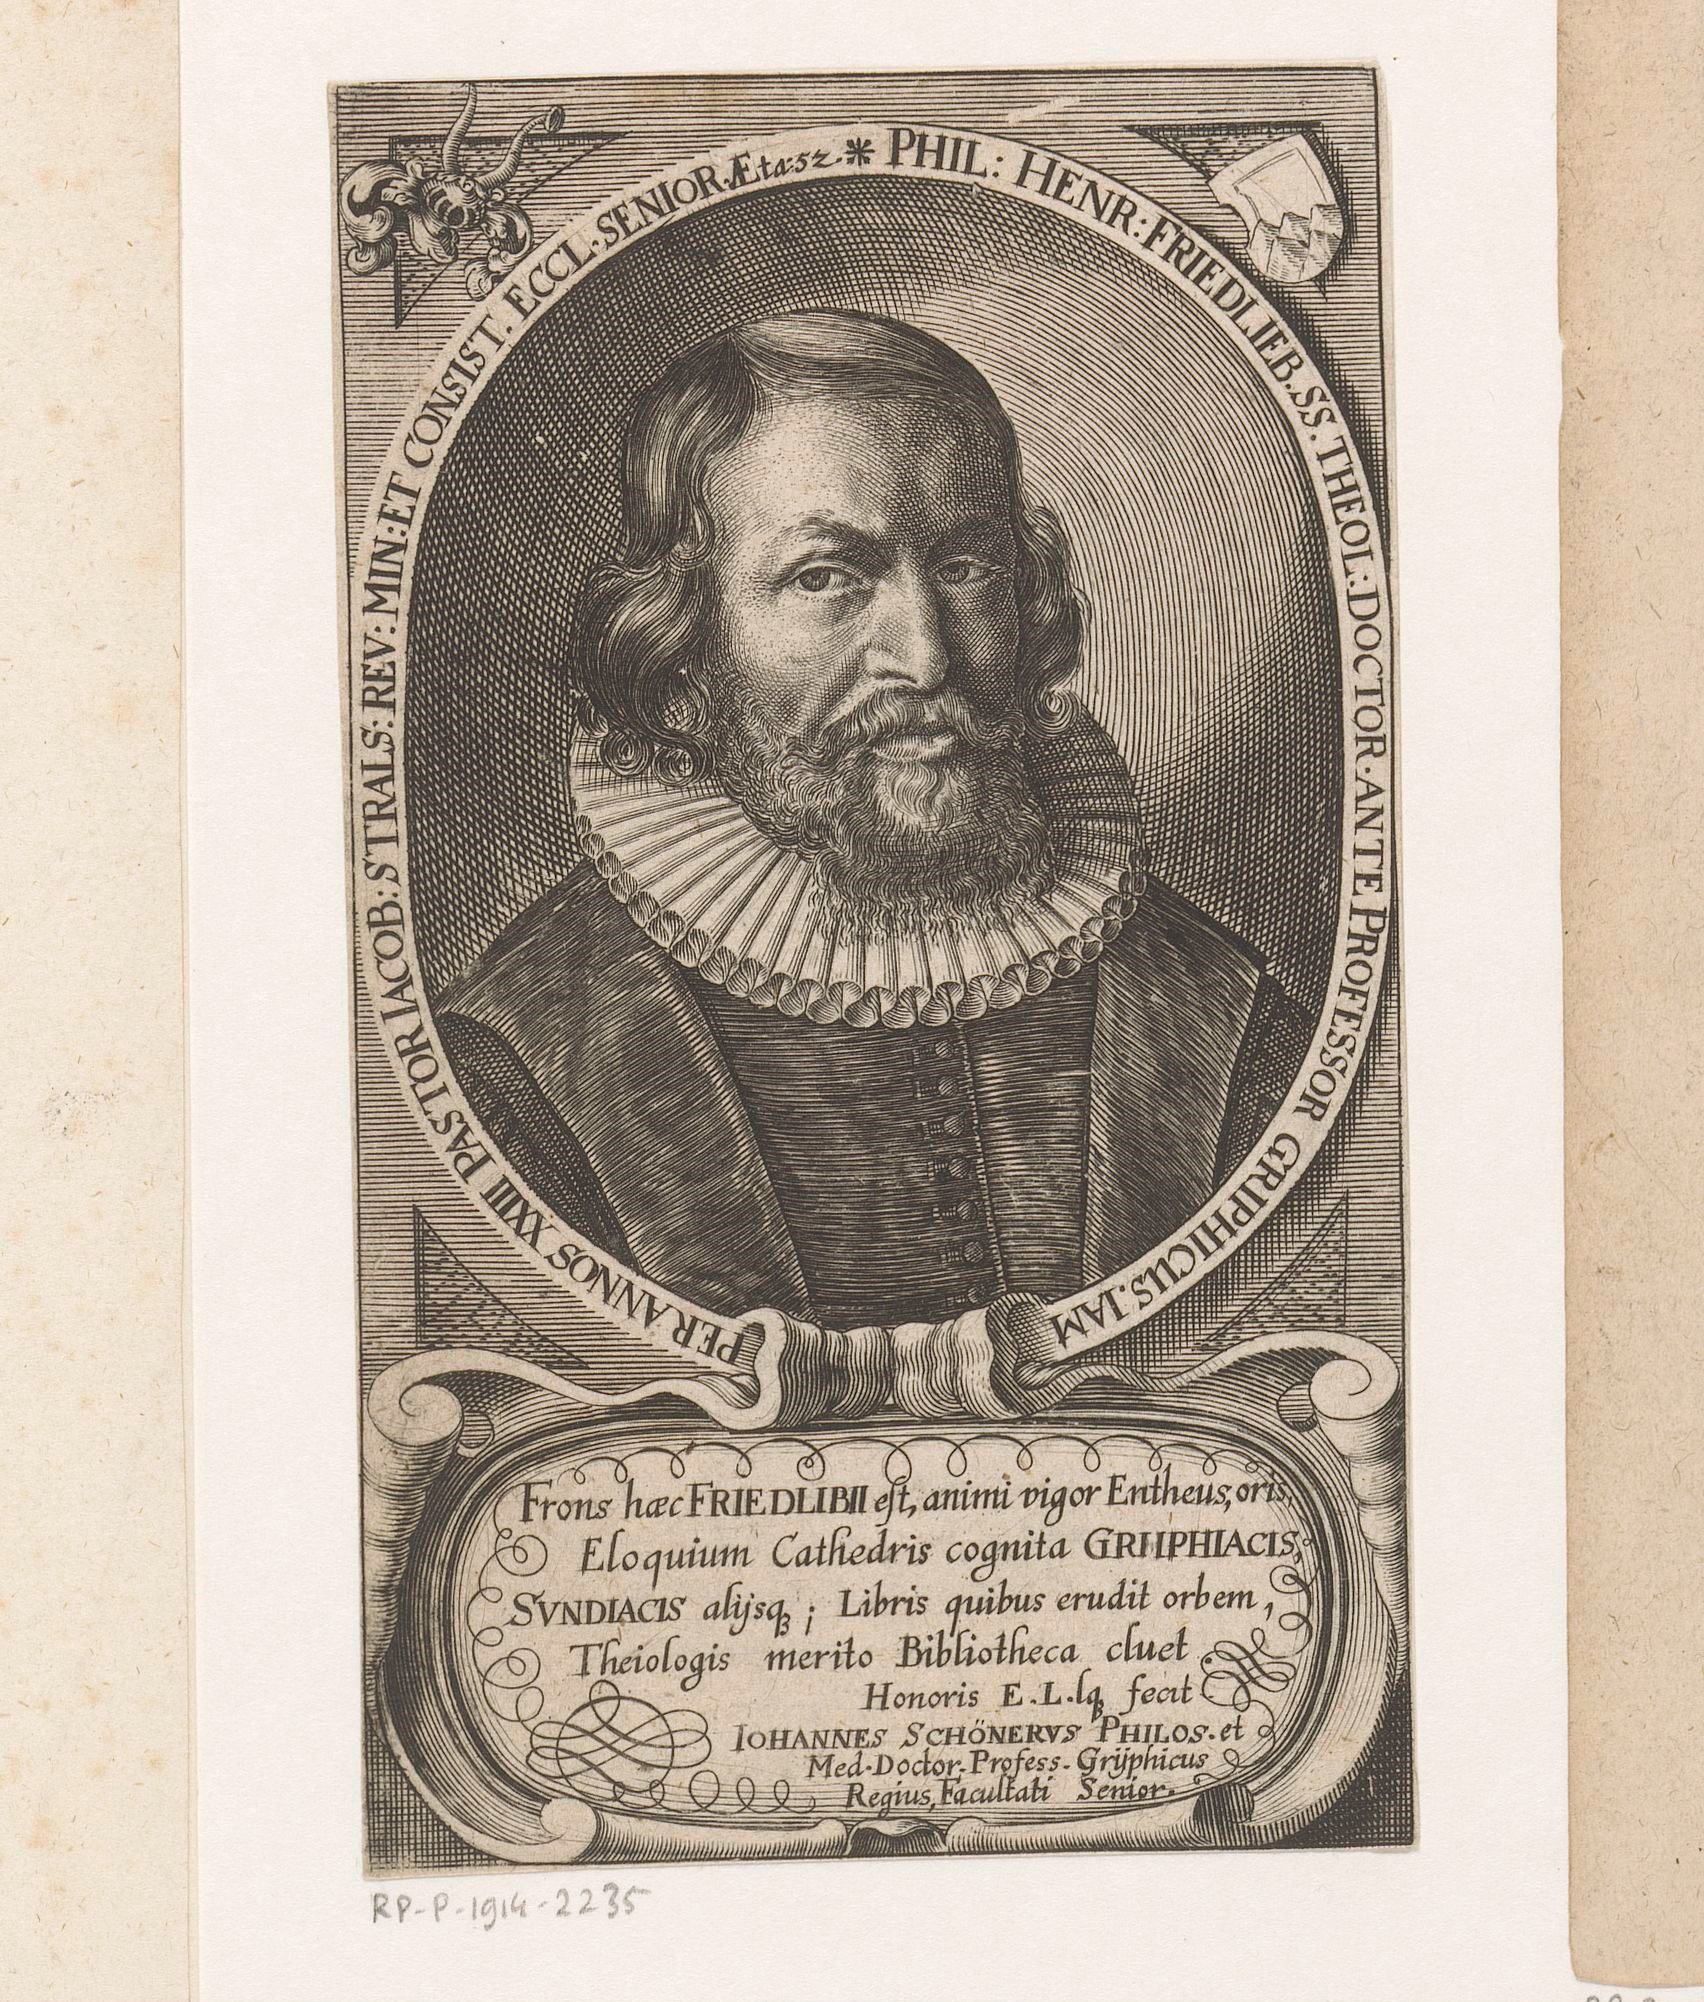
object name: print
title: Portret van Philipp Heinrich Friedlieb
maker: johann schöner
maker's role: decaan, medicus, schrijver, wiskundige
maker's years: 1597-1657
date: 1652-1700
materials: paper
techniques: engraving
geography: greifswald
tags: historical persons, armorial bearing, heraldry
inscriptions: collector's mark: Lugt 2228